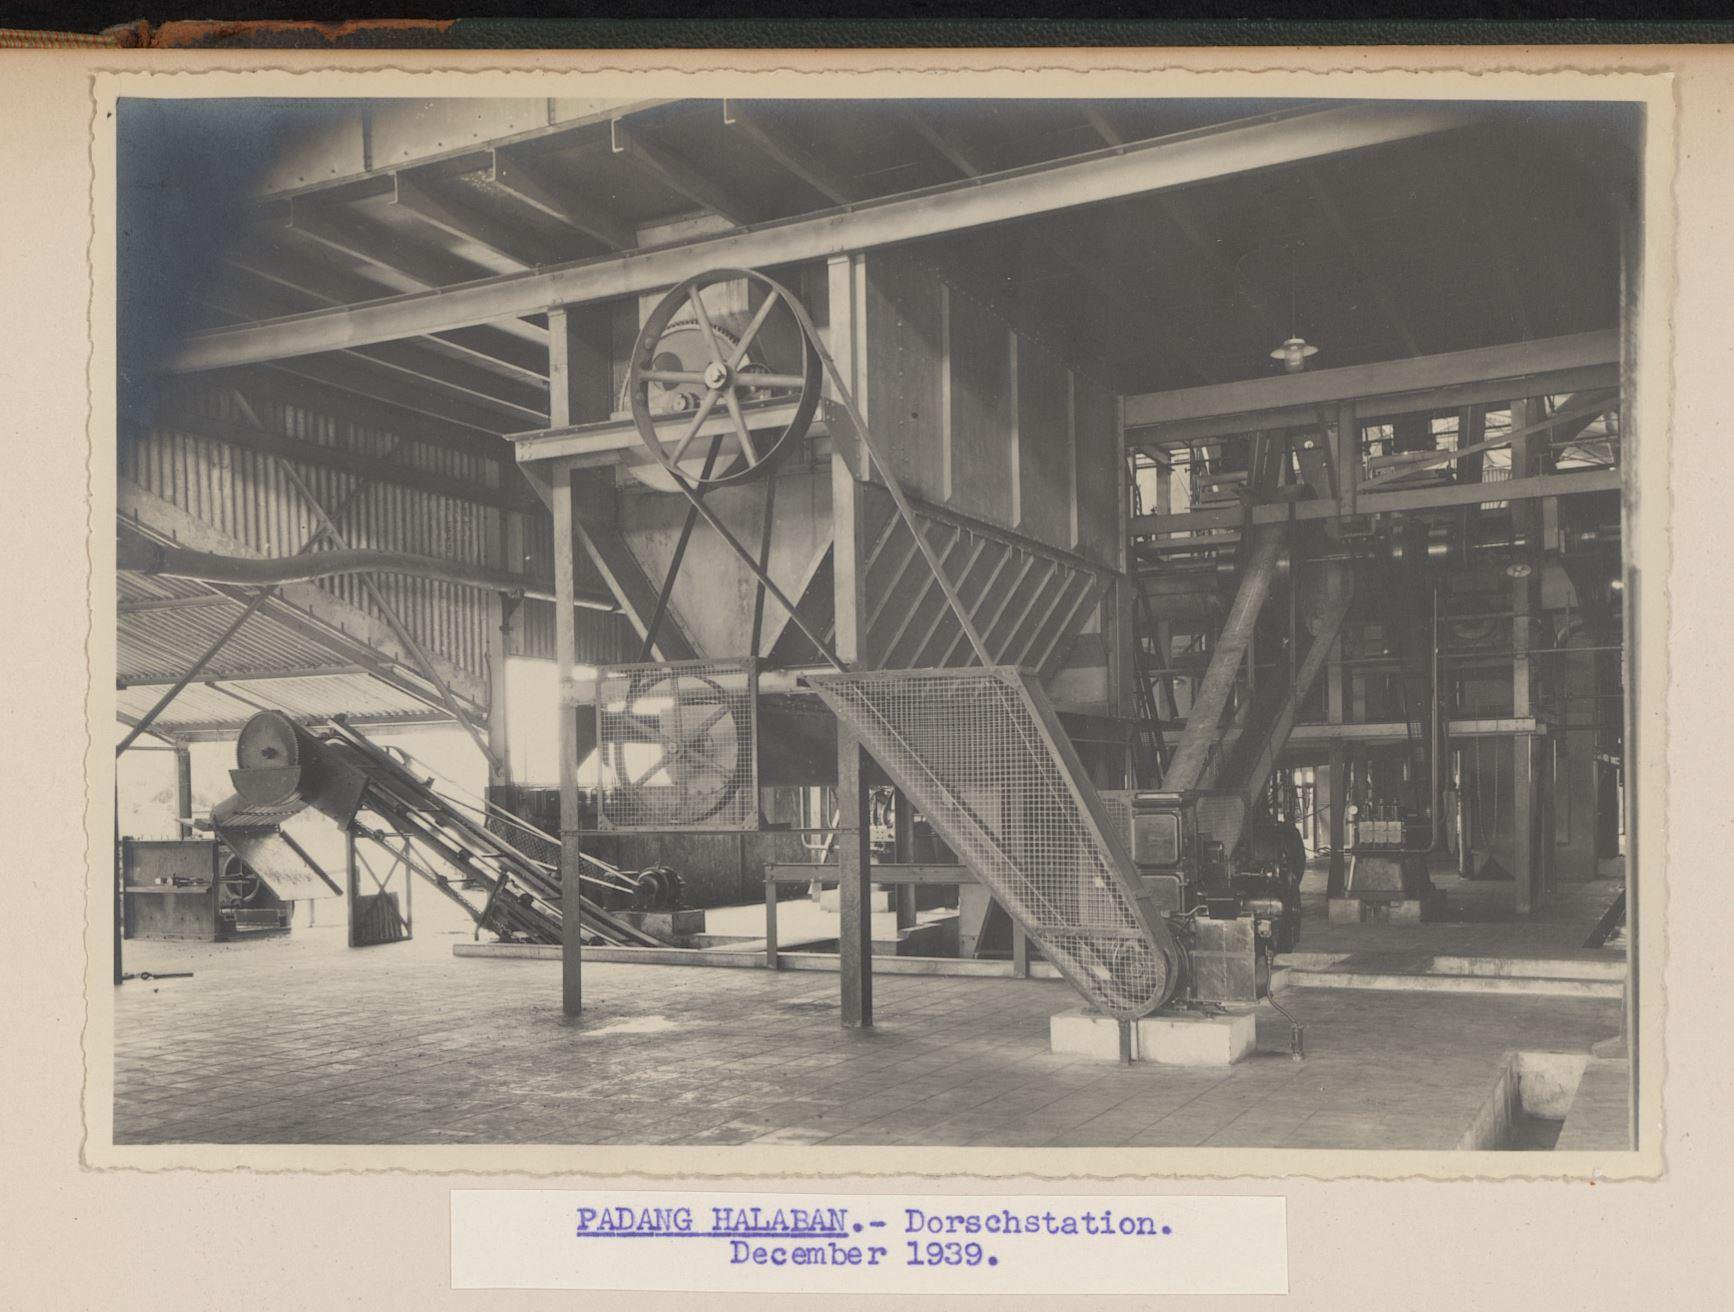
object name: photograph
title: Padang Halaban - Dorschstation. December 1939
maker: Anonymous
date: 1912-1939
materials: photographic support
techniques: gelatin silver print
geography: sumatra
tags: plantation, factory-interior, machine shop, (non-fruit) products of plants or trees: palm oil, sumatra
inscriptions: inscription: ‘Padang Halaban - Dorschstation. December 1939’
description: De dorsmachine in de fabriek voor palmolie bij de plantage Padang Halaban, december 1939. Onderdeel van het fotoalbum over de plantages Pernantian en Brussel van de Sumatra Caoutchouc Maatschappij op de Oostkust van Sumatra in de jaren 1935-1939.